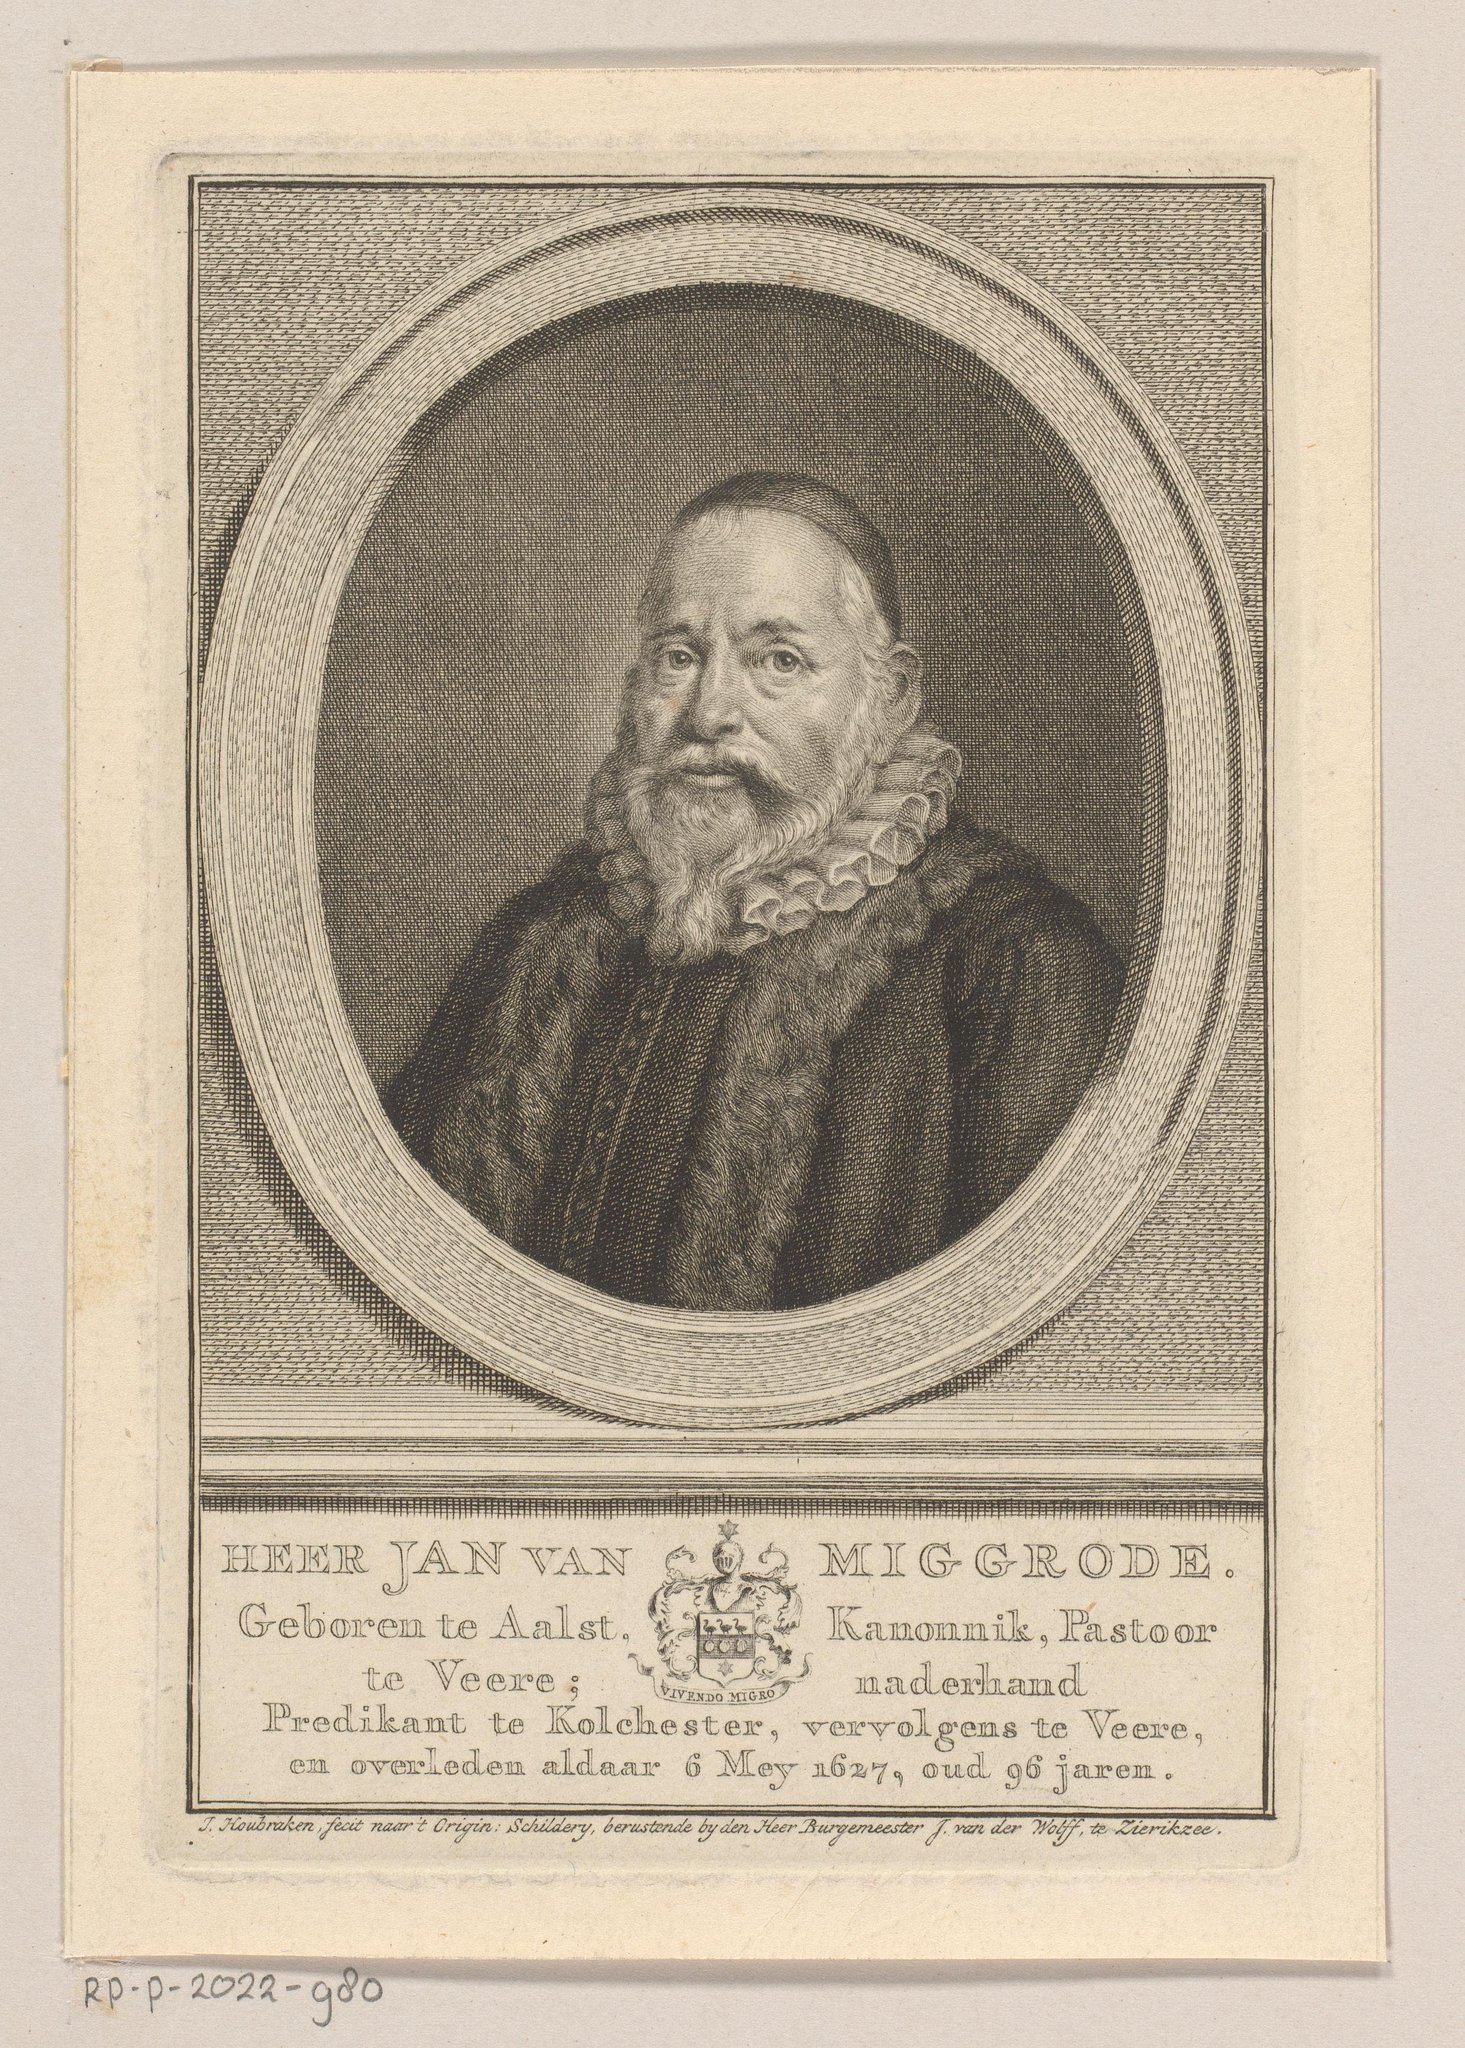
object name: print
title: Portret van Johannes van Miggrode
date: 1710-1780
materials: paper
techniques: engraving, etching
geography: amsterdam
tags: historical persons, organization, functionaries and dignitaries in churches and in related institutions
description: Met vierregelig onderschrift in het Nederlands.